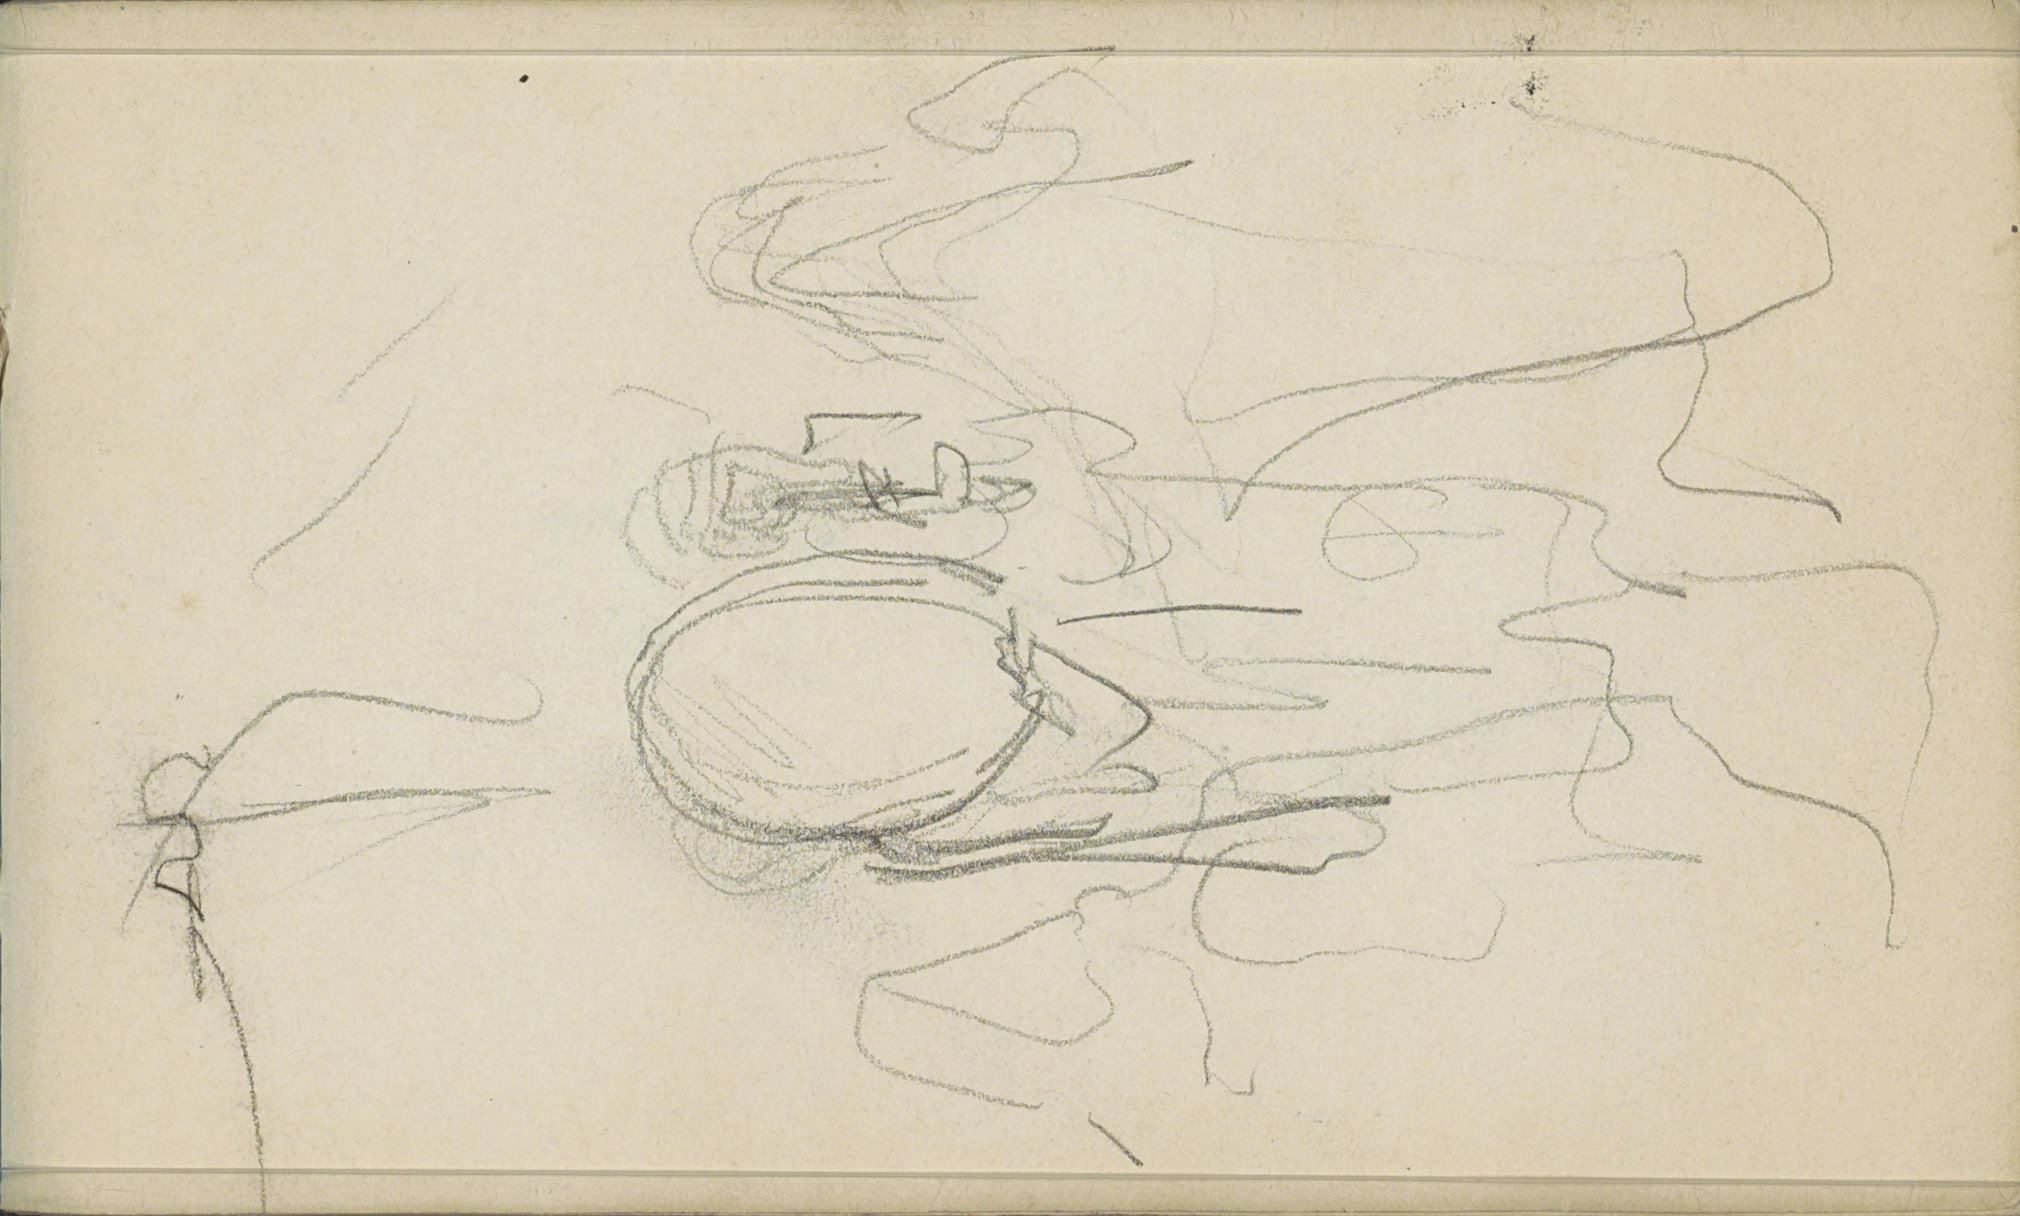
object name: sketchbook leaf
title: Groep Algerijnen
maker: marius bauer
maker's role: draughtsman, print maker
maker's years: 1867-1932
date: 1922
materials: paper, pencil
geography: biskra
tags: making music; musician with instrument, africans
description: Mogelijk zijn de figuren aan het musiceren. Eén man lijkt een fluit te bespelen, een ander draagt mogelijk een slagwerkinstrument. Pagina 1 uit een schetsboek met 31 bladen.